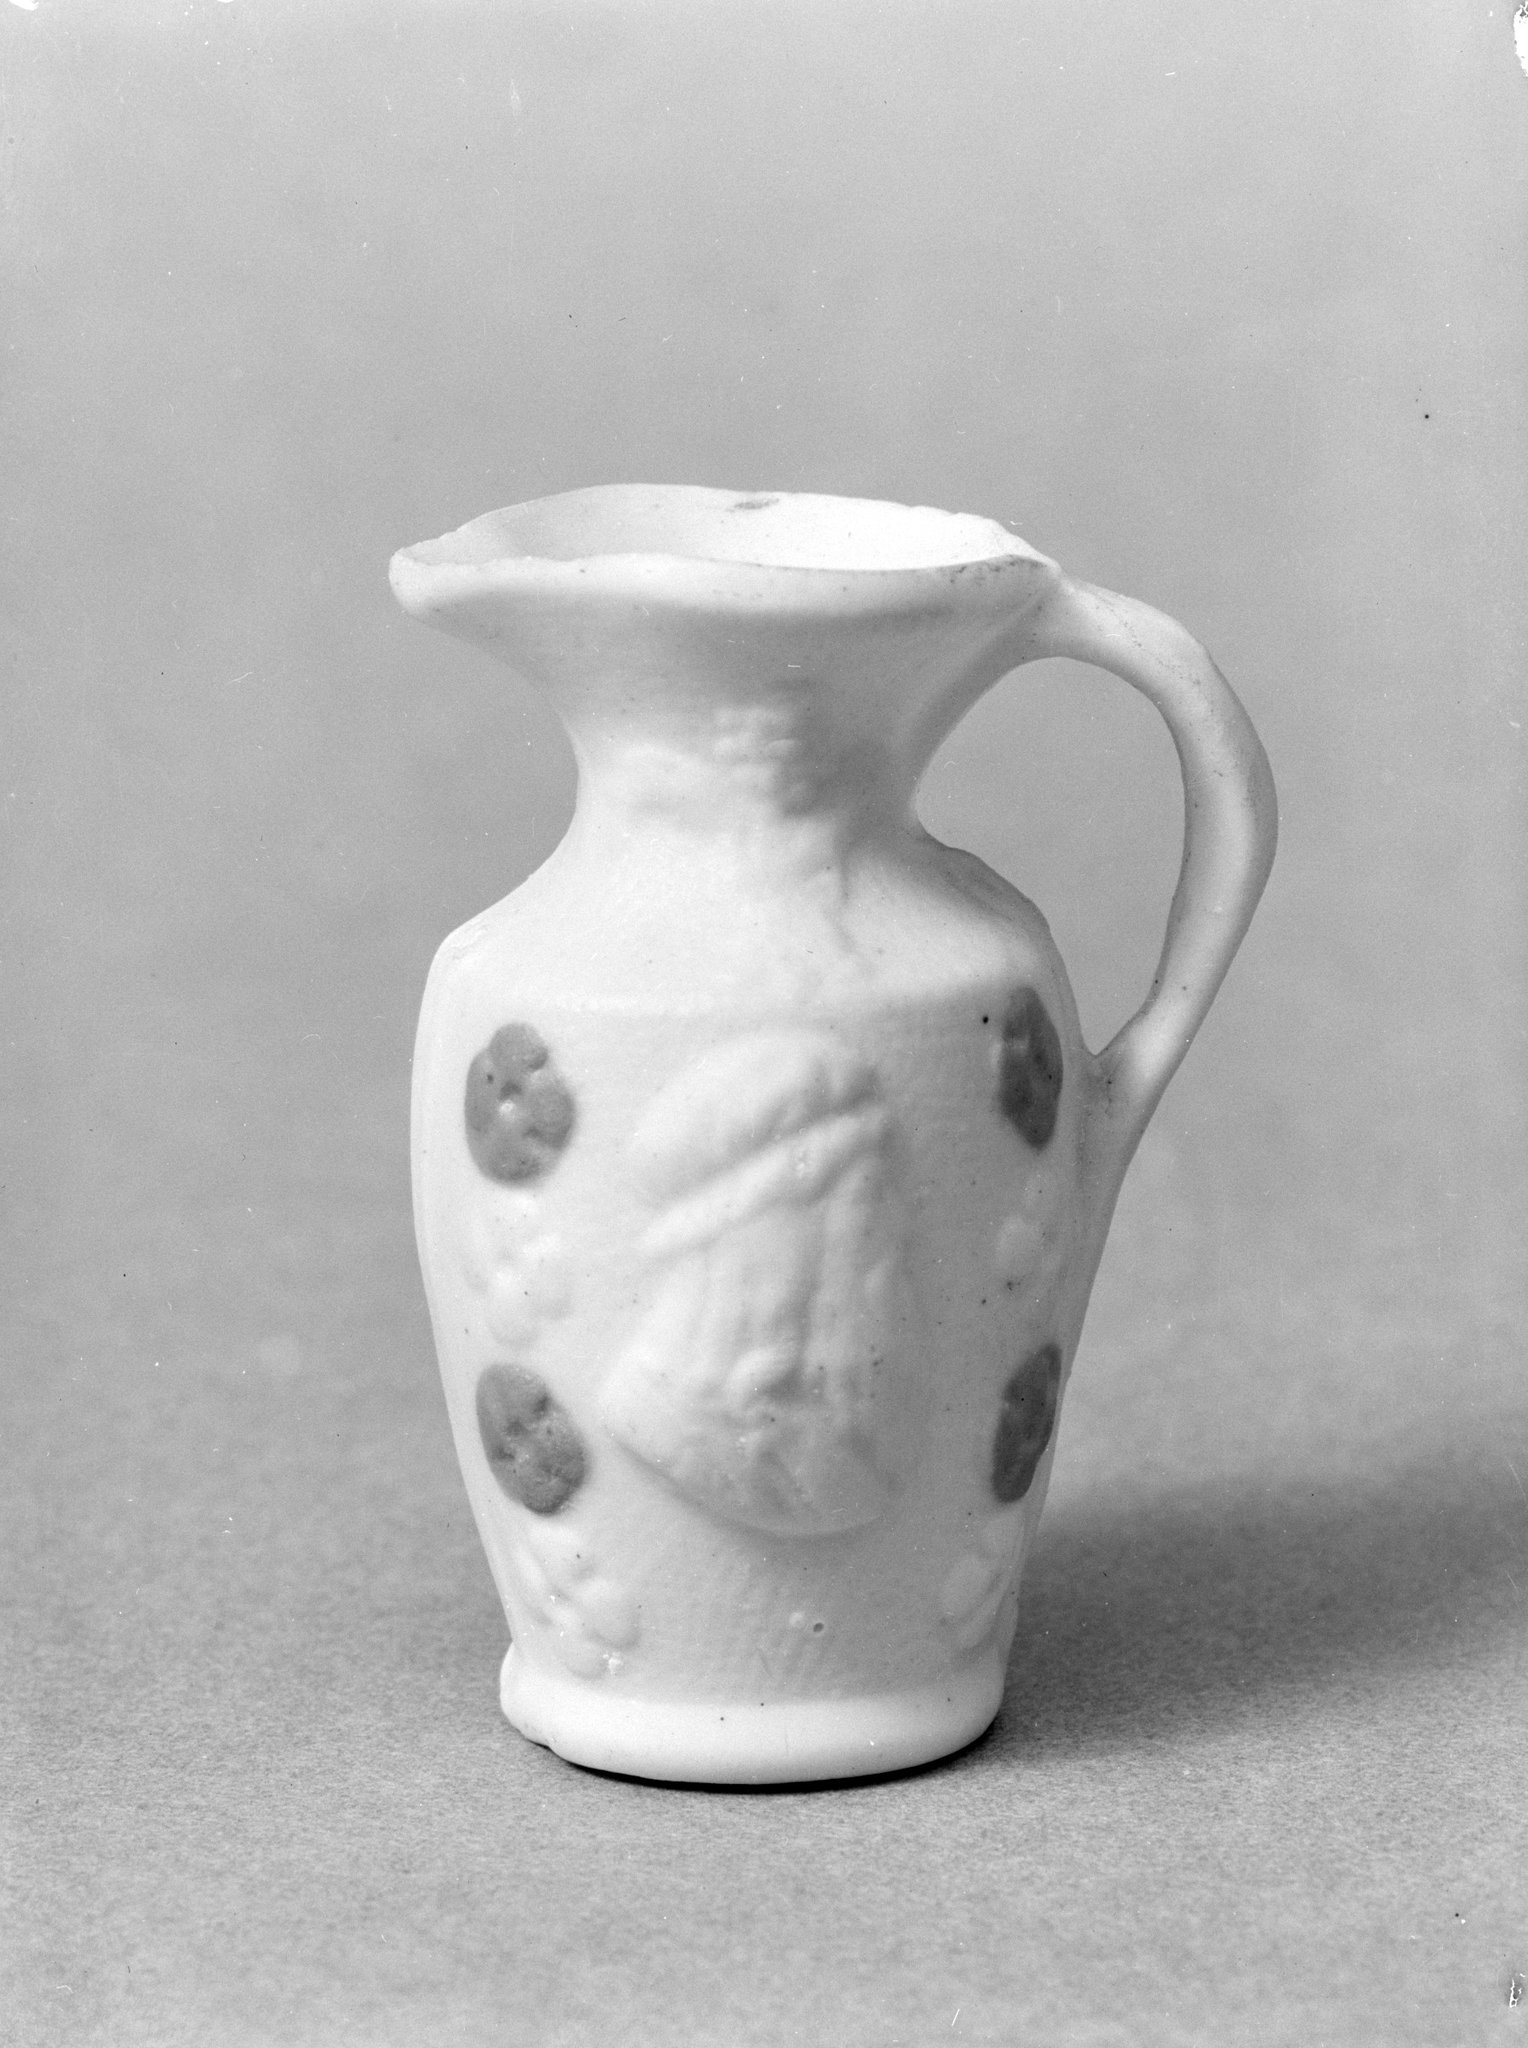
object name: pitcher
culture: american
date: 1830-1870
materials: porcelain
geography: united states